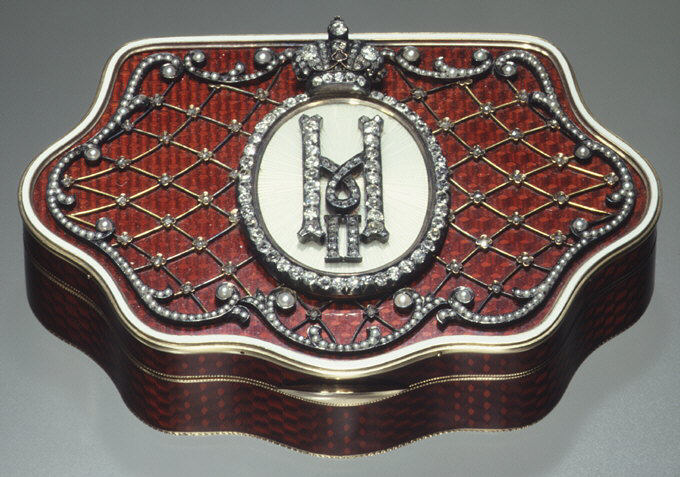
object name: snuffbox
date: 1867-1900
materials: diamond, enamel, gold